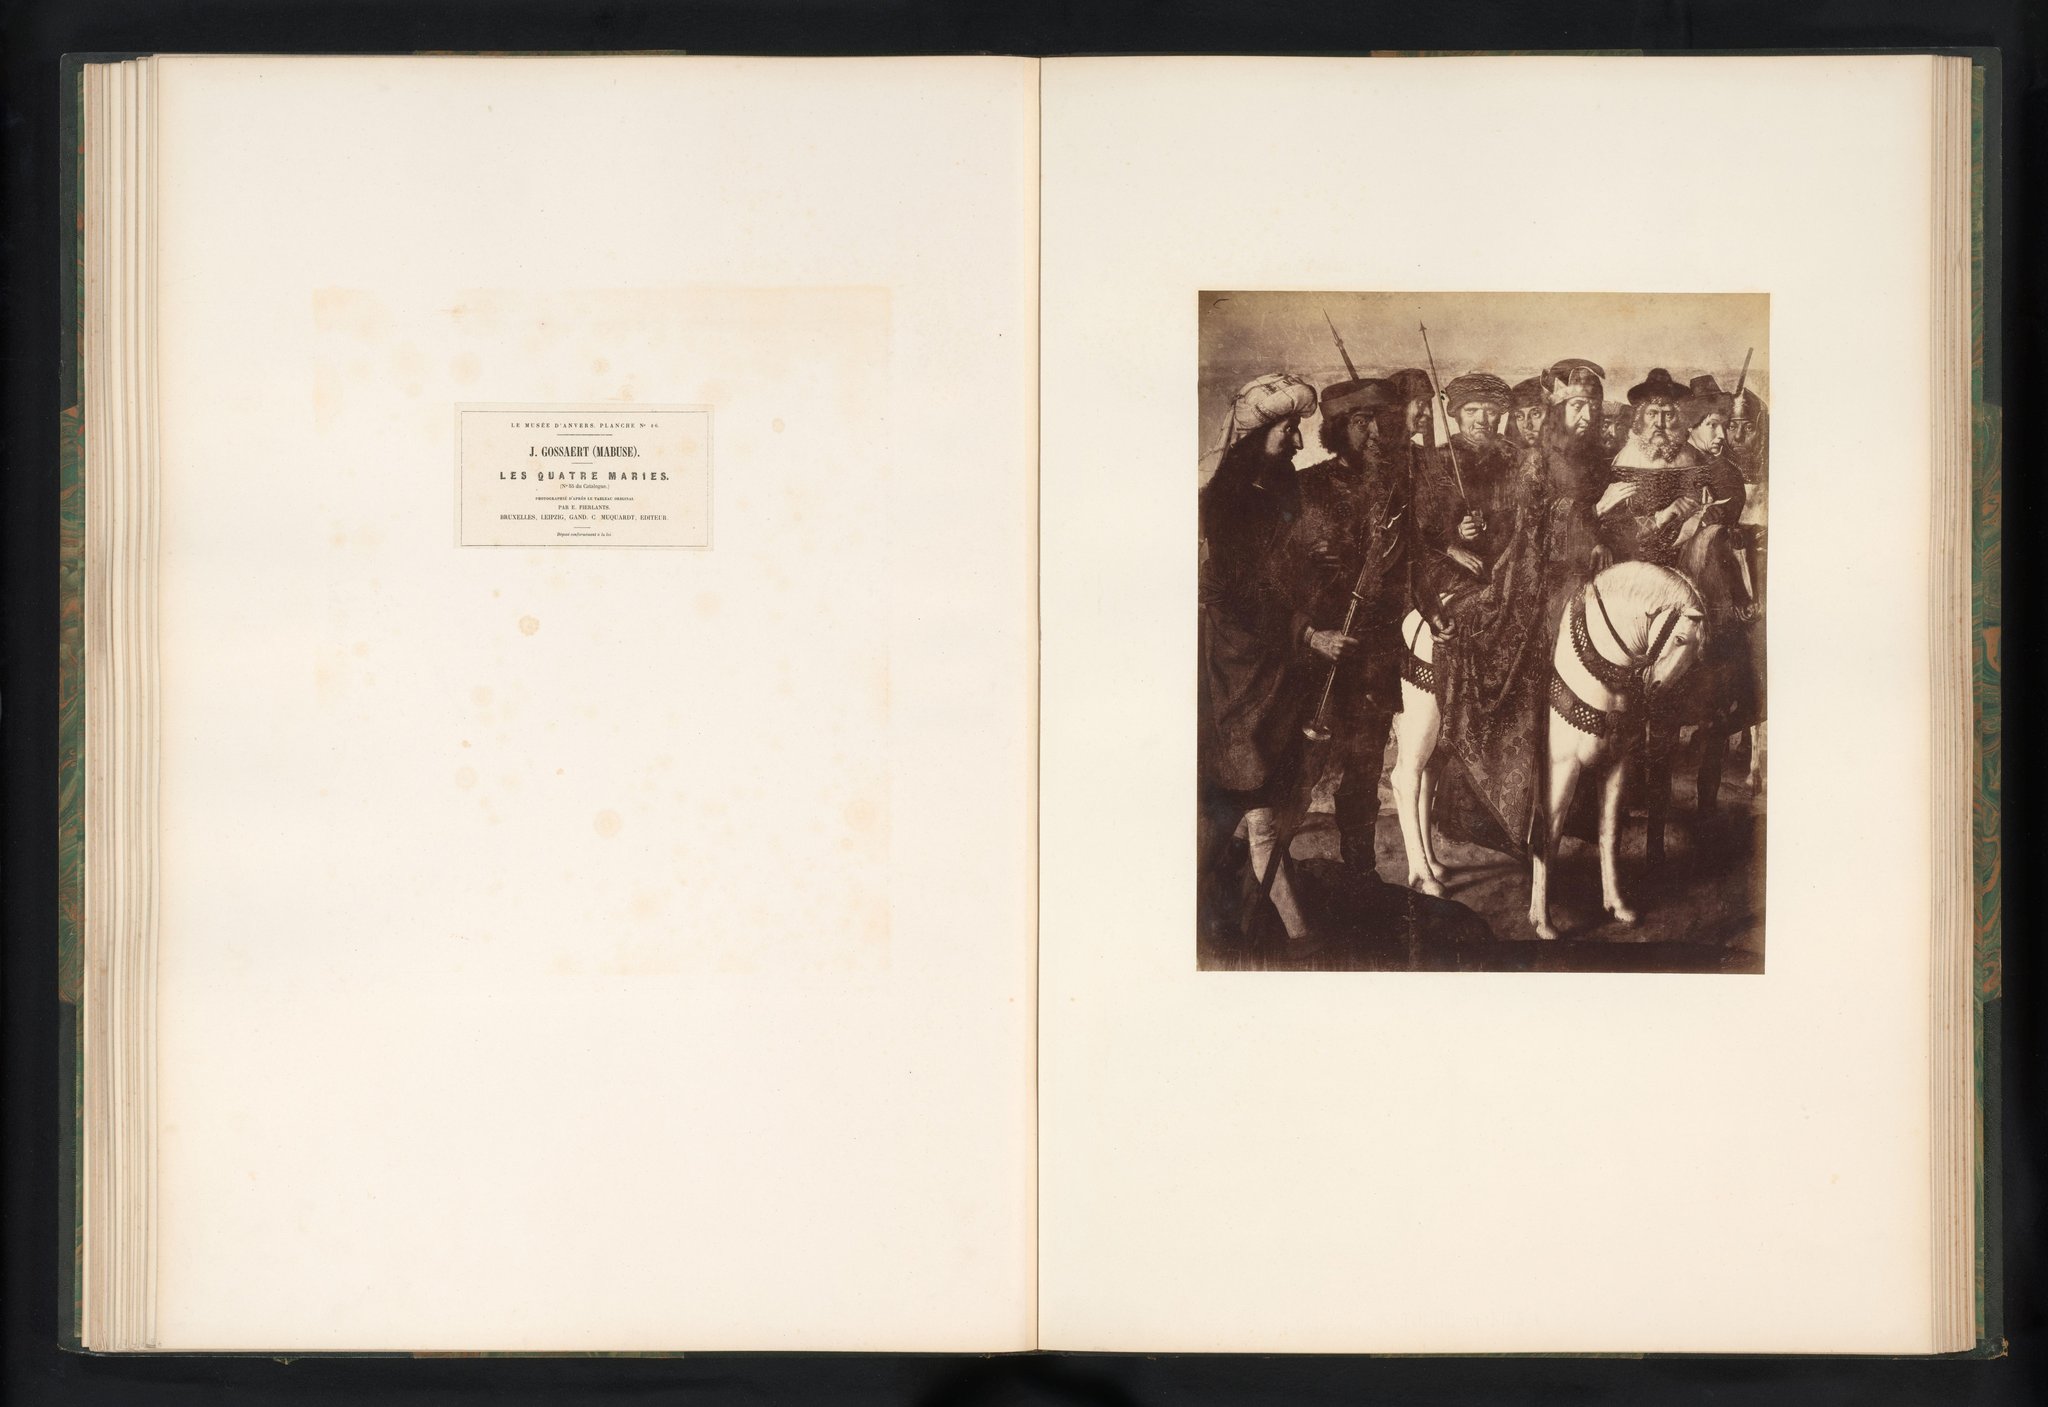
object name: page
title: Fotoreproductie van Pilatus en de hogepriesters door Jan Gossaert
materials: photographic support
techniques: albumen print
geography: brussels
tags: the priests complain about the superscription; pilate refuses to change it